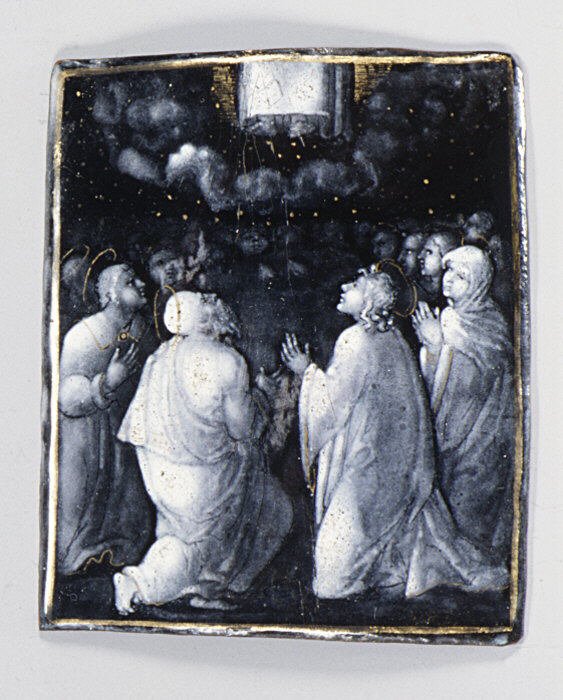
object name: plaque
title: The Ascension of Christ (one of seven)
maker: jean ii pénicaud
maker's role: enameler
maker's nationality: french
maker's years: 1524-1554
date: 1534-1566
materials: copper, enamel, gilt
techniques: painting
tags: men,women,christ